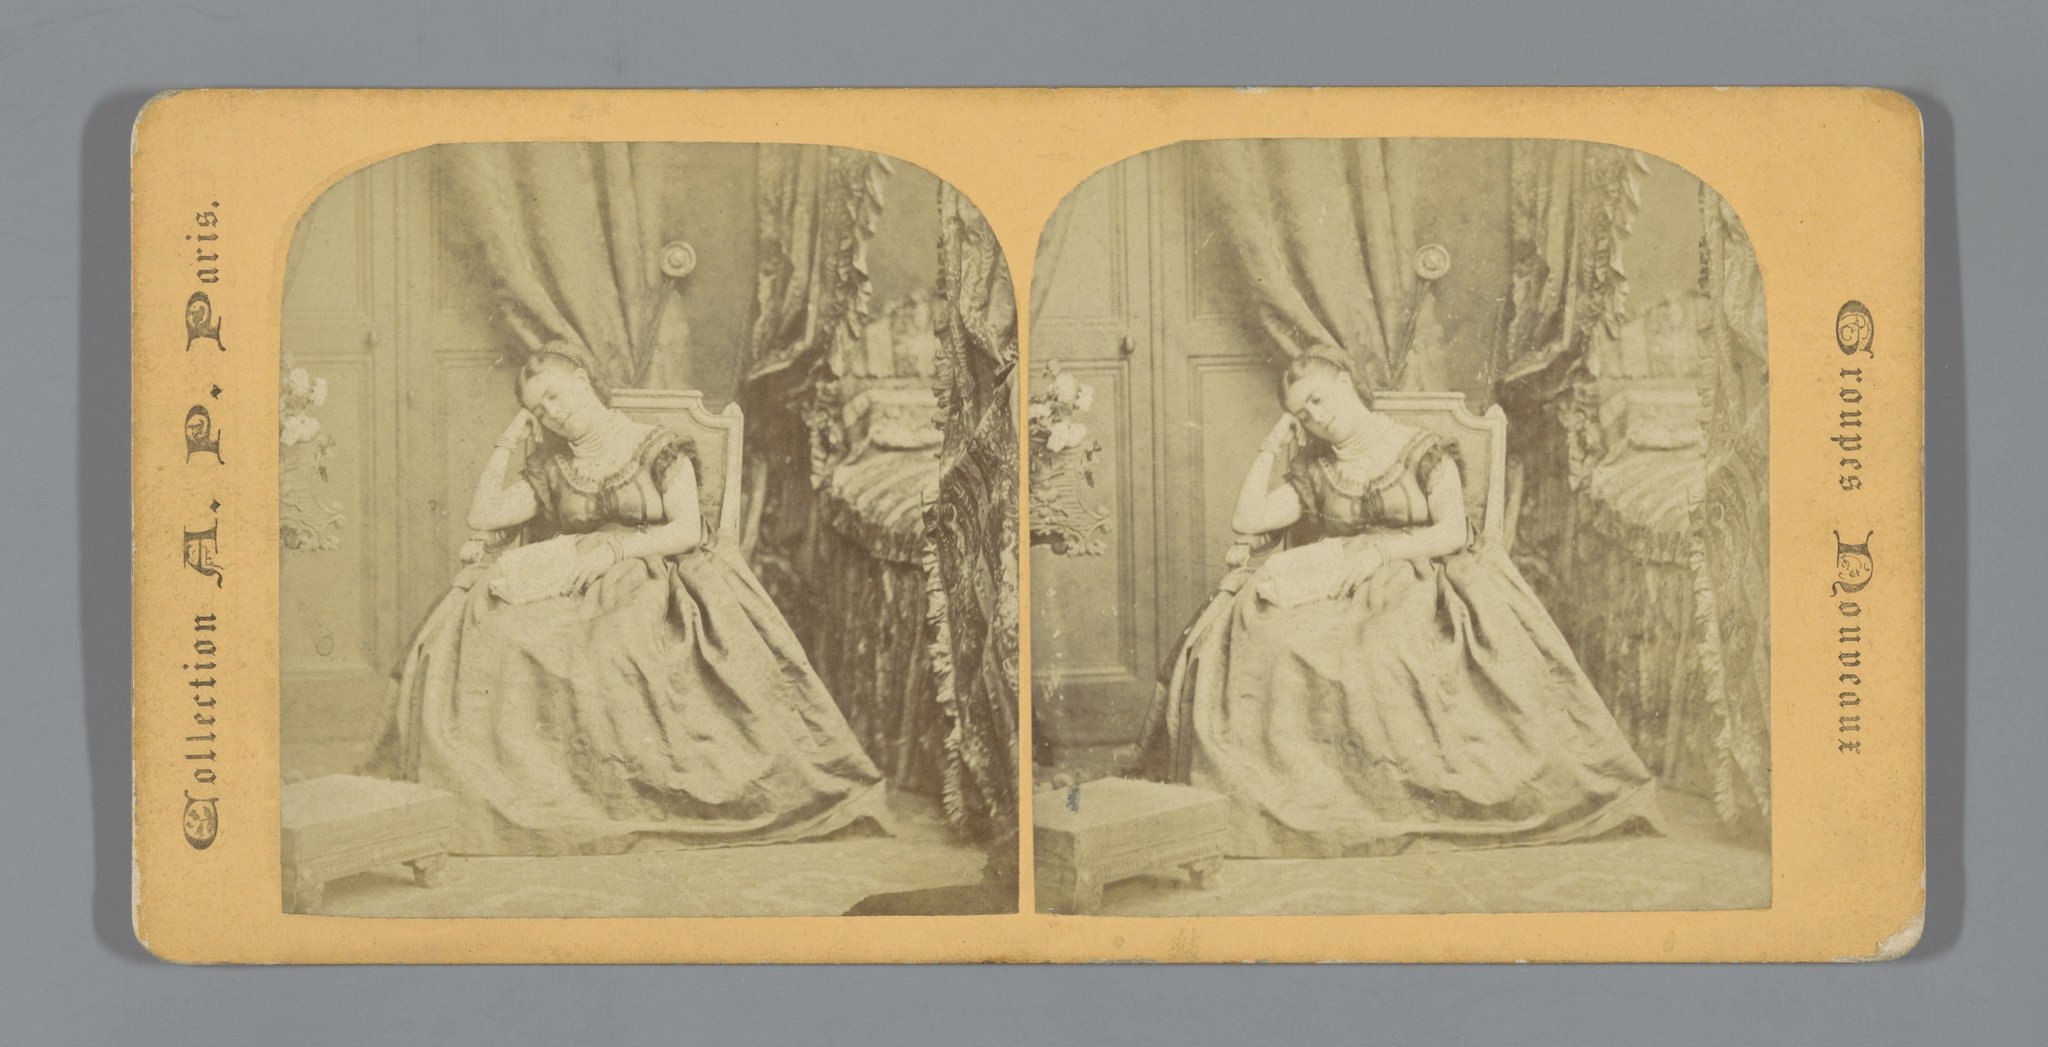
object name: stereograph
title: Groupes Nouveaux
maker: anatole pougnet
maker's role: publisher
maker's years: 1840-1900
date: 1855-1870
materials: cardboard, photographic support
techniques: albumen print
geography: paris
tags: sleeping in chair, book, bedroom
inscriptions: monogram: ‘Collection A.P. Paris’